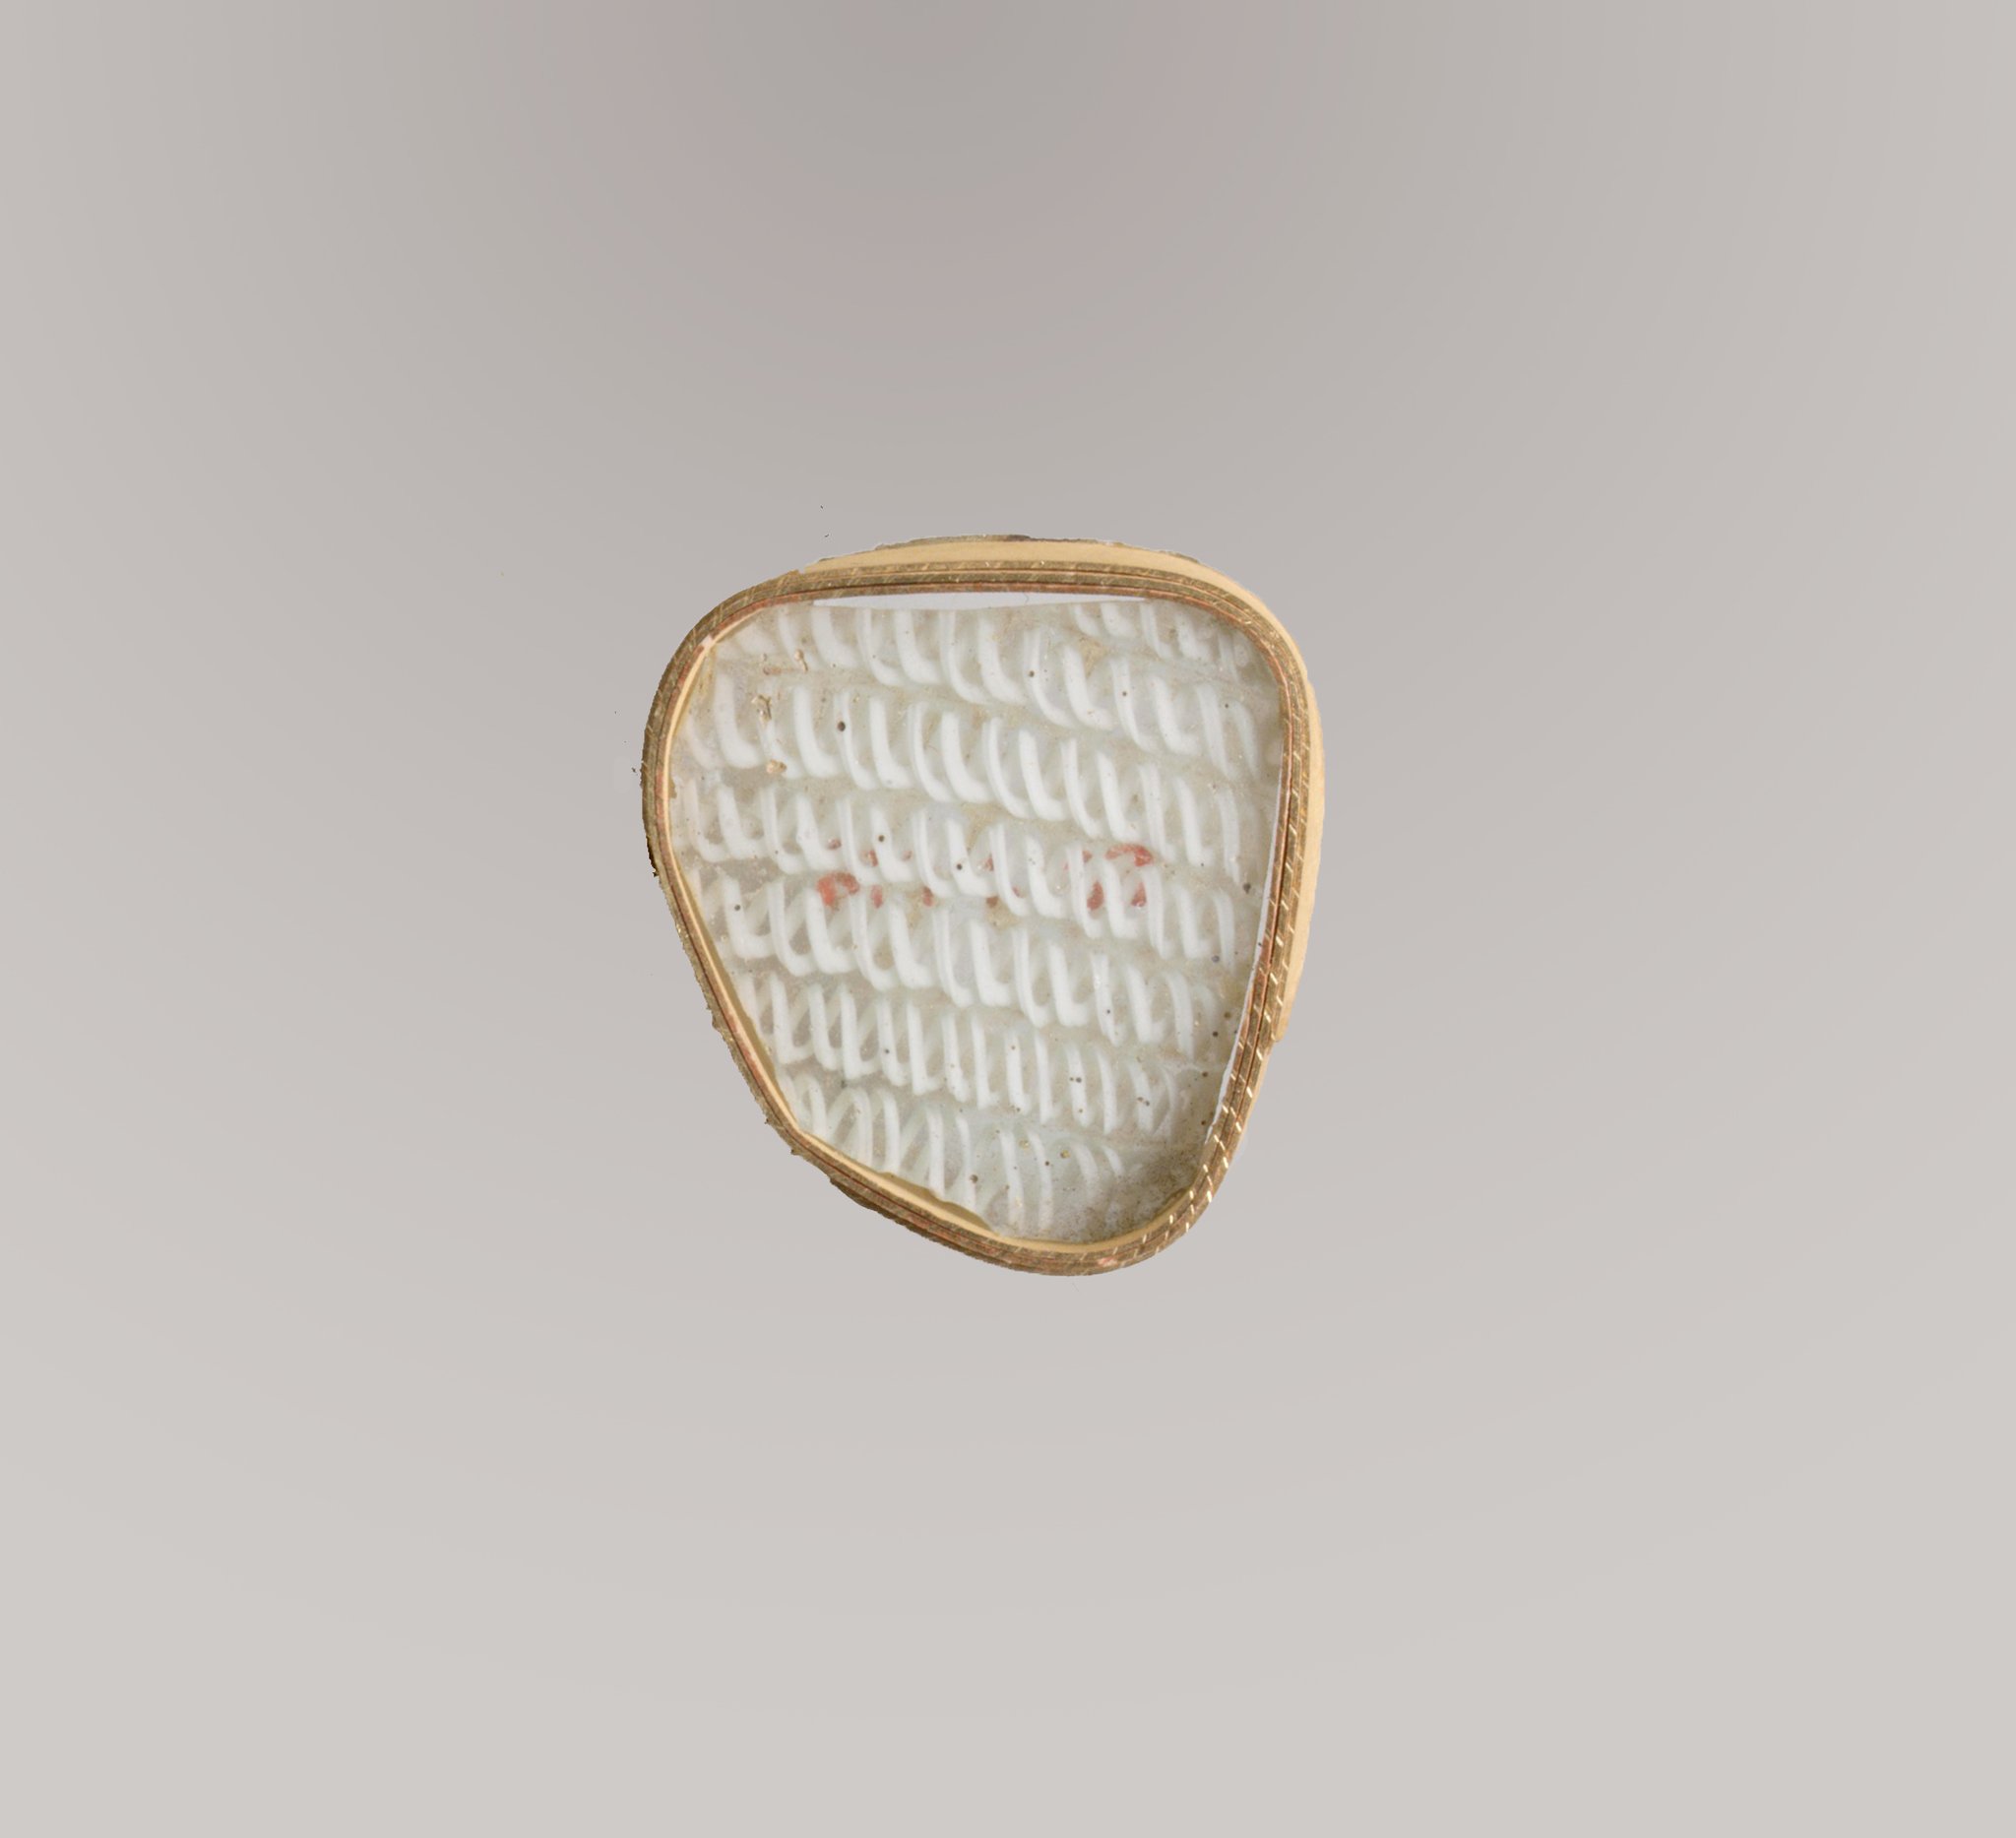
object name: fragment, network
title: Glass network mosaic fragment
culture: roman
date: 34 BCE-33 CE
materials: glass